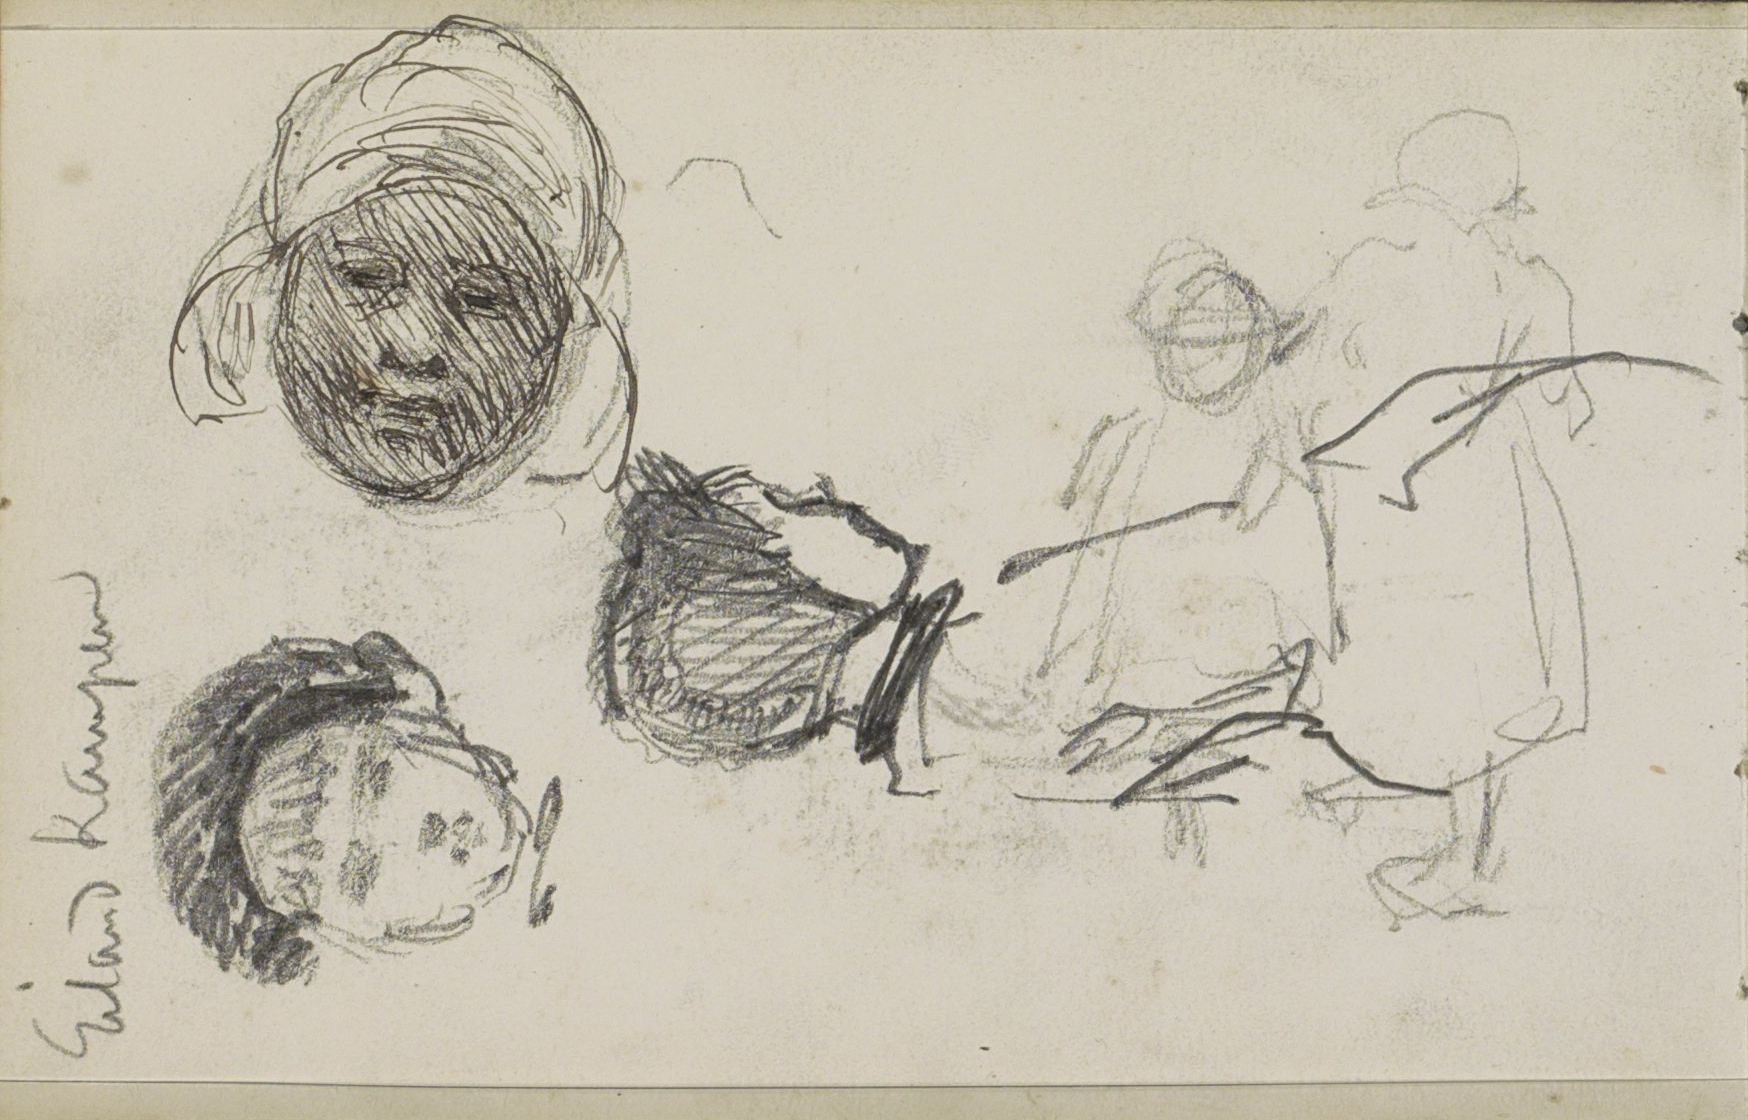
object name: sketchbook leaf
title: Inwoners van het Kampereiland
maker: george clausen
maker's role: draughtsman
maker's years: 1852-1912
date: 1875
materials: ink, paper, pencil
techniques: pen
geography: kampereiland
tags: head (human), folk costume, regional costume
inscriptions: annotation: ‘Eiland Kampen’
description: Blad 10 verso uit een schetsboek met 38 bladen.